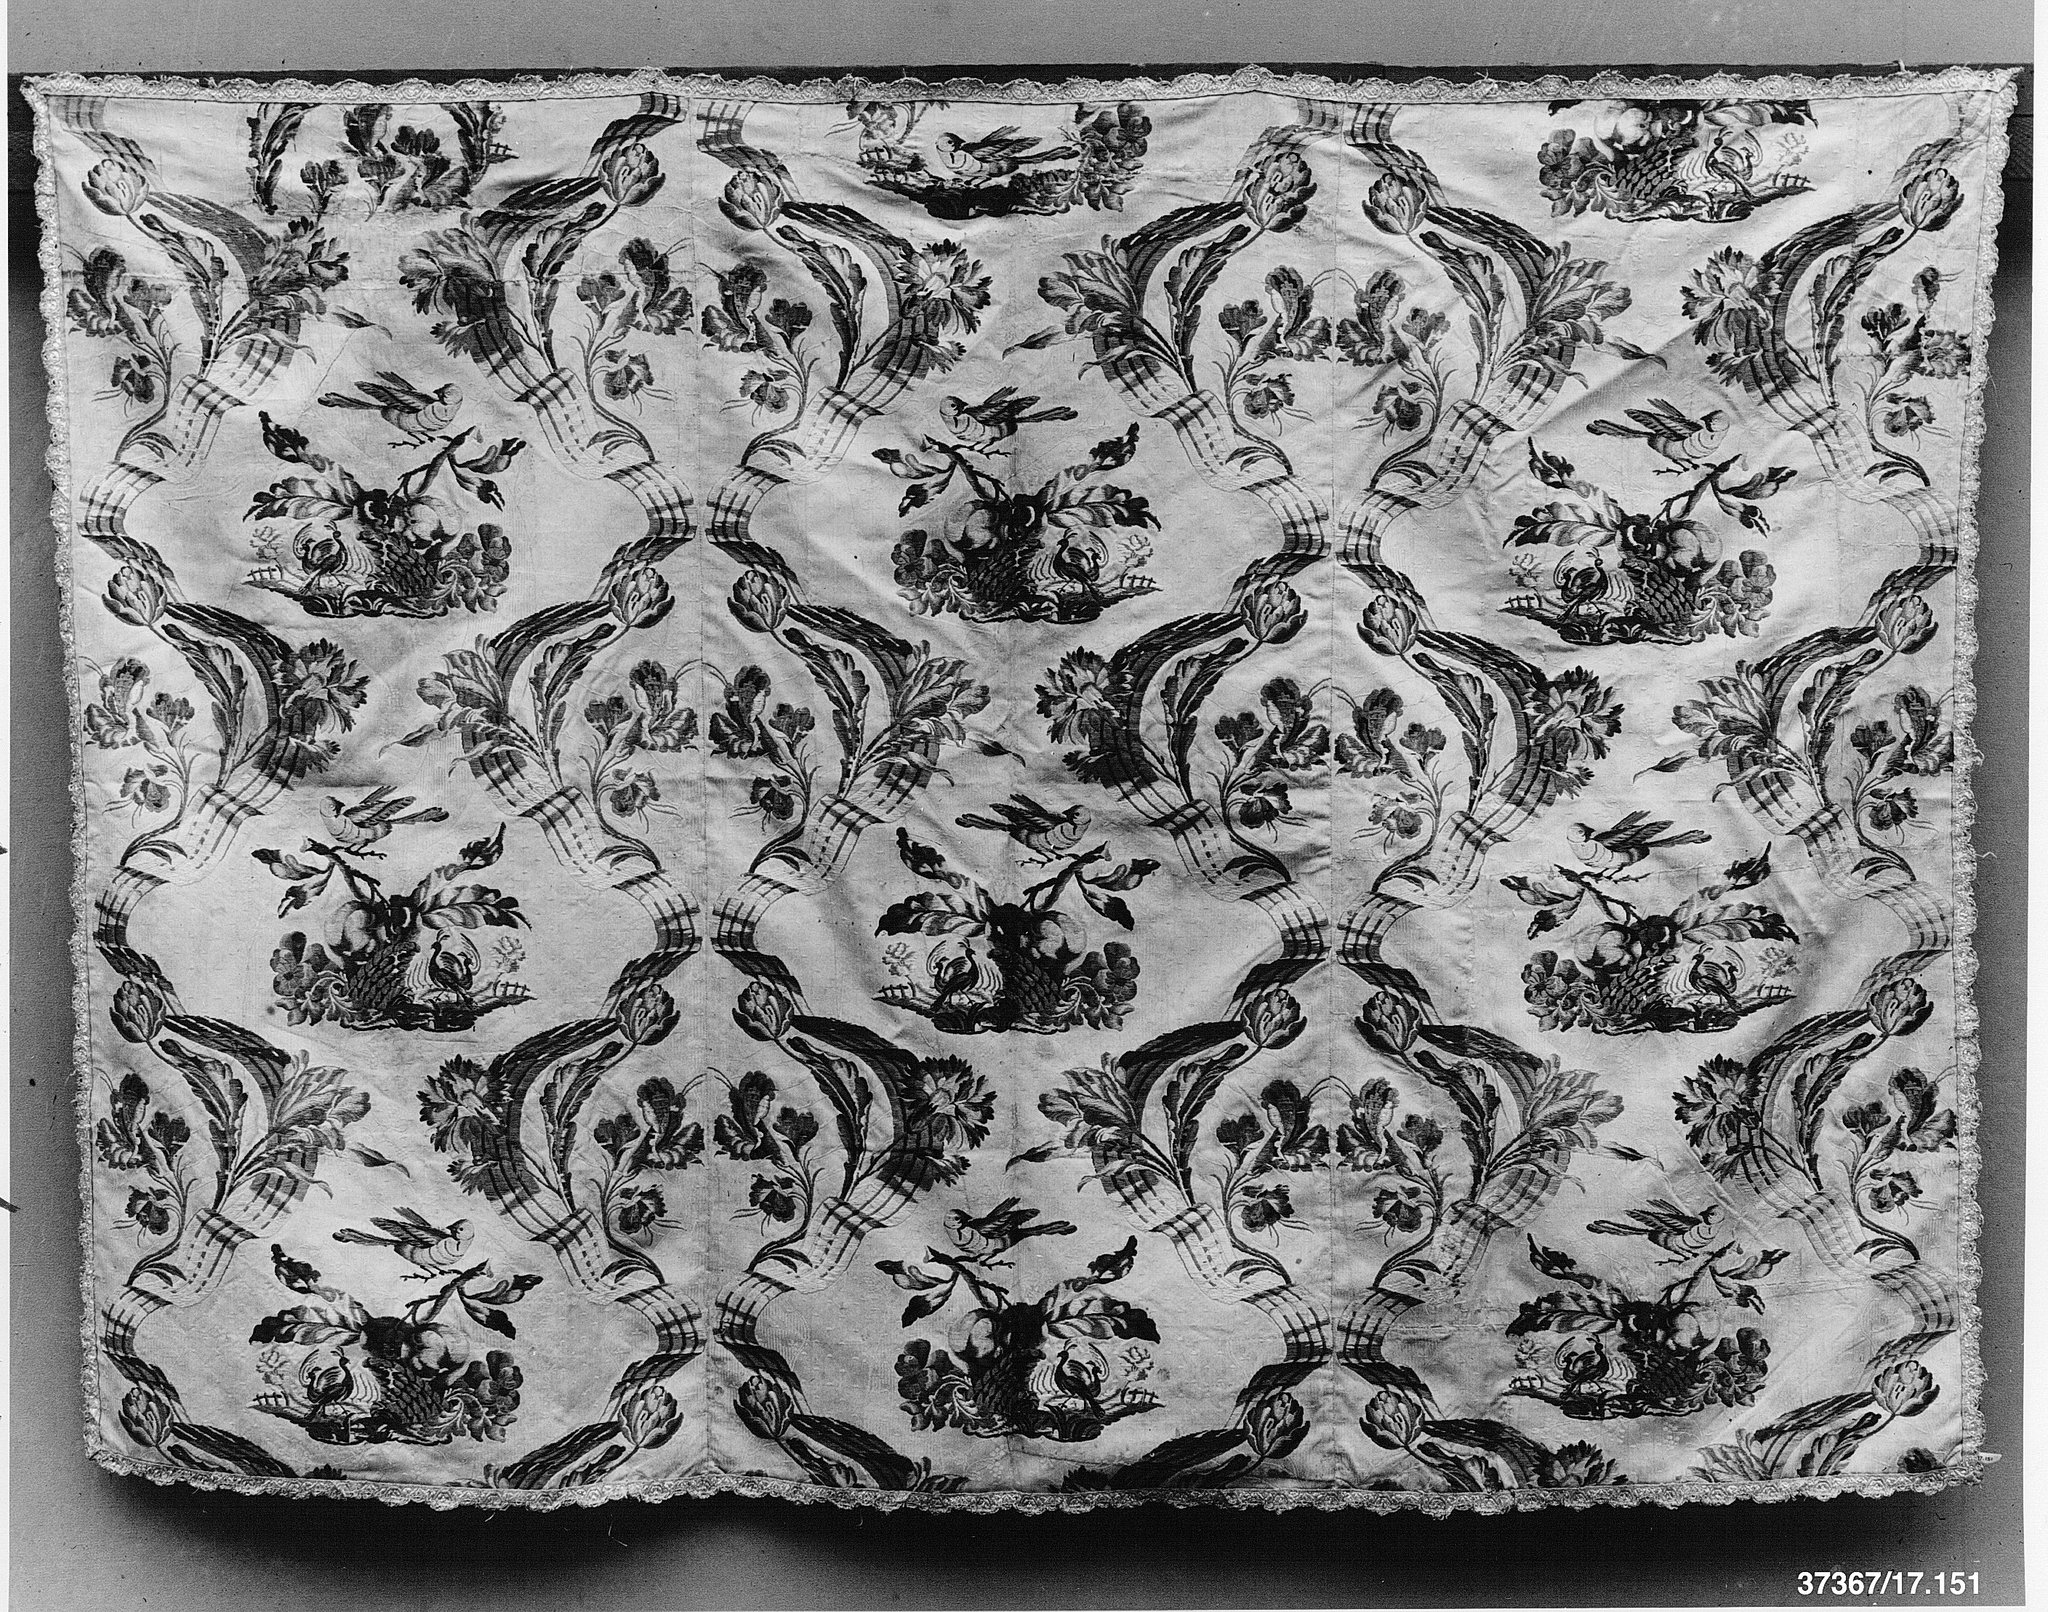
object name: piece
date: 1750-1760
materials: silk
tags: birds,flowers